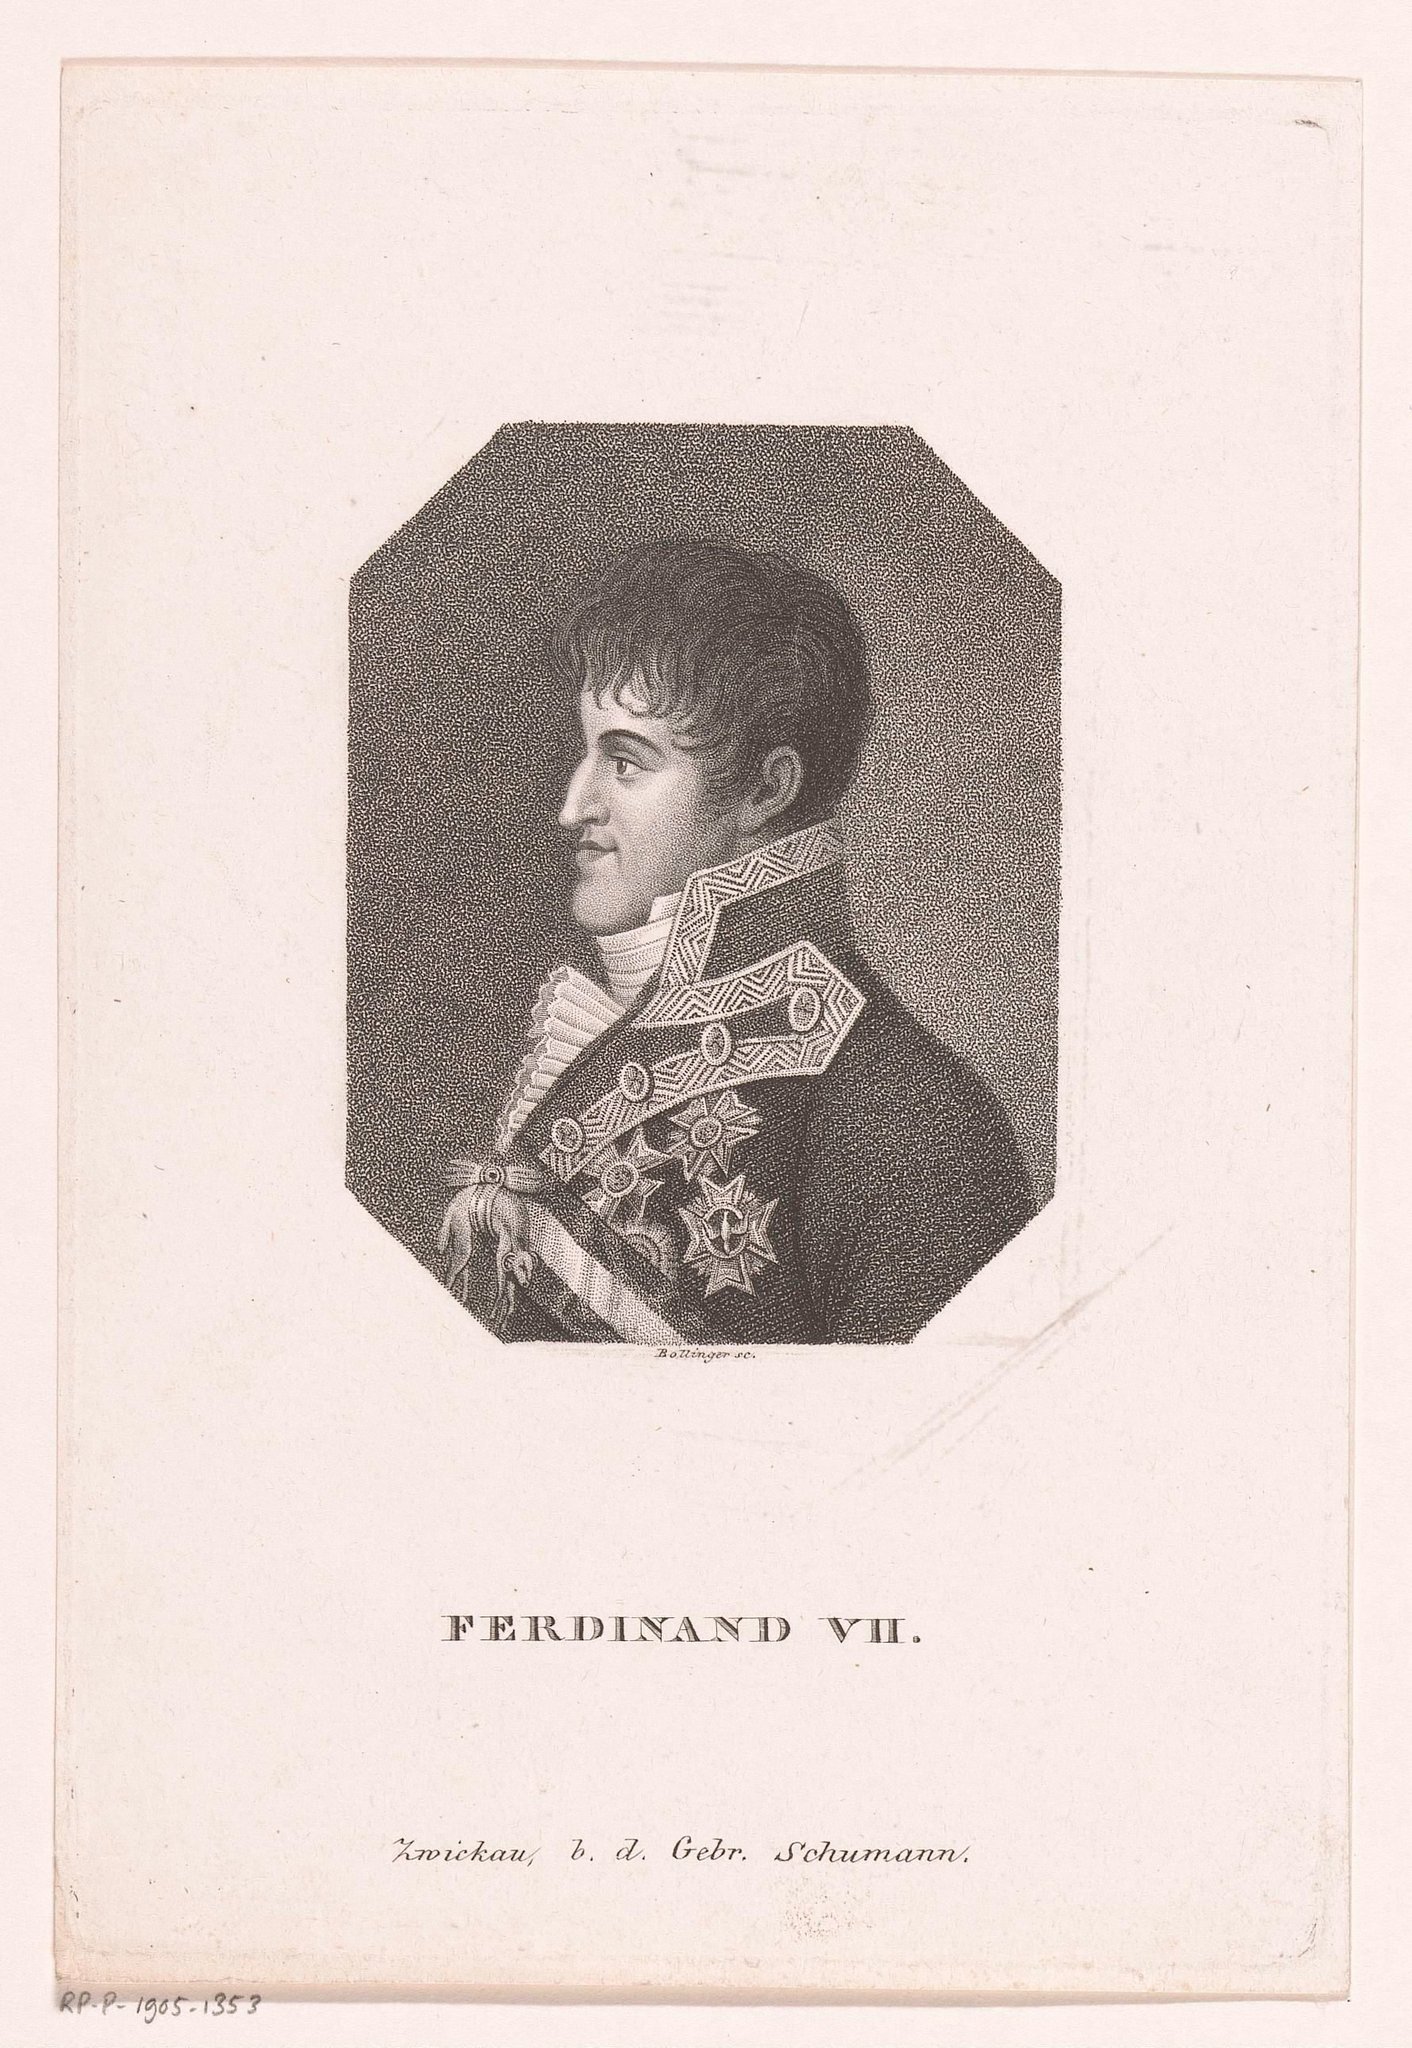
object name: print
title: Portret van Ferdinand VII, koning van Spanje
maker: friedrich wilhelm bollinger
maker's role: print maker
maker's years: 1777-1825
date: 1818-1832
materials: paper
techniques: stippling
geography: zwickau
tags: ferdinand vii (koning van spanje), knighthood order, historical persons, knighthood order of the golden fleece - insignia of a knighthood order, e.g.: badge, chain (with name of order), (military) uniforms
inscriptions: collector's mark: Lugt 2228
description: Prent gebruikt door de serie 'Bildnisse der berühmtesten Menschen aller Völker und Zeiten' van de gebroeders Schumann, uitgegeven in 1818-1832 te Zwickau.